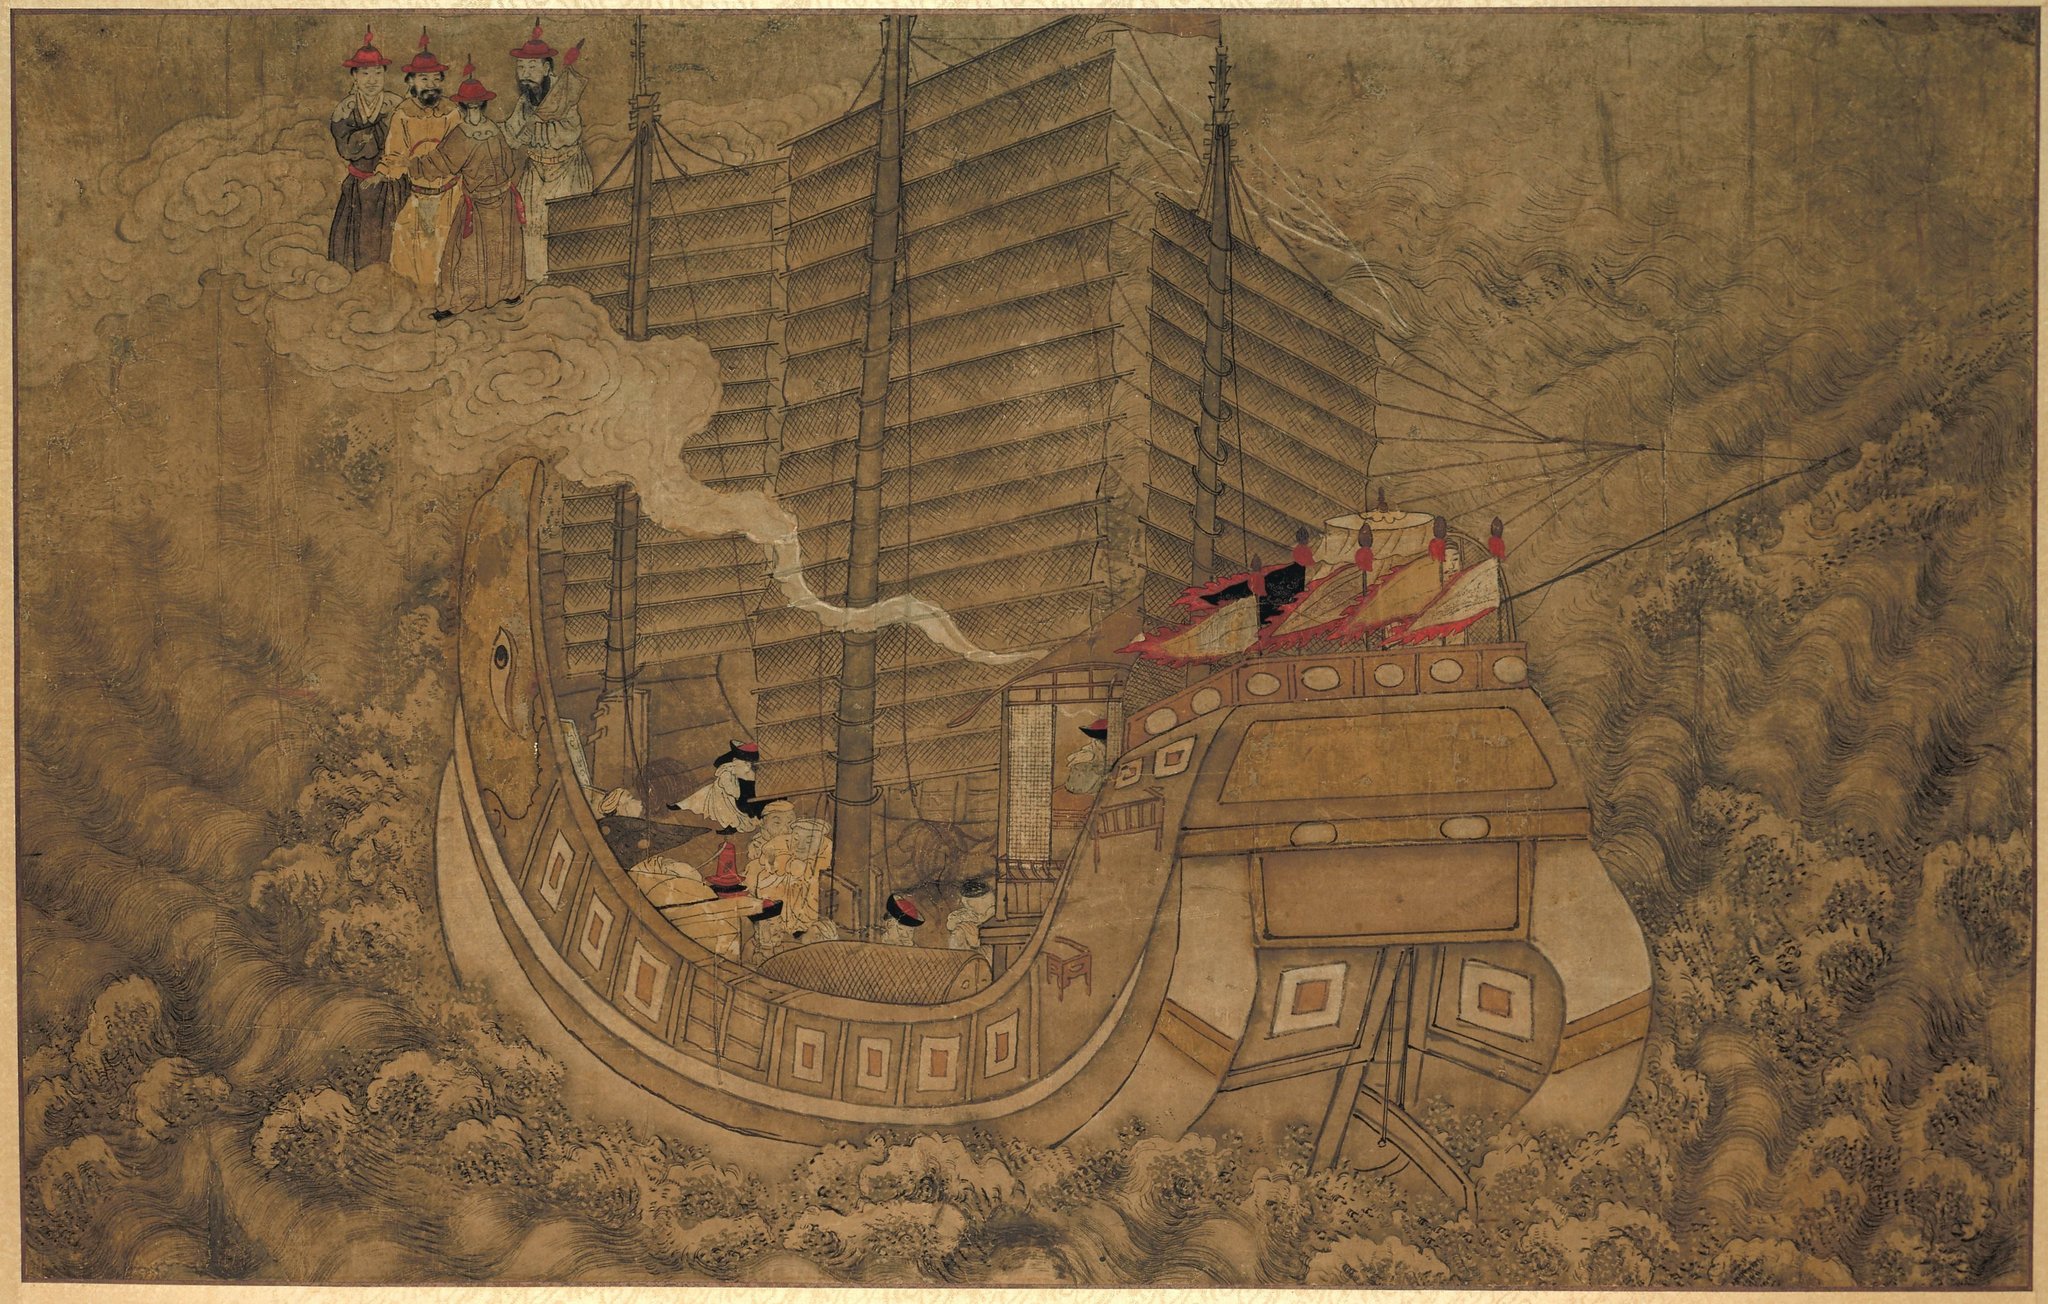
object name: album leaf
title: De wonderen van Mazu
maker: Anonymous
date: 1700-1800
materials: ink, paper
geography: china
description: Eén van een serie van zeven schilderingen die samen de wonderen van Mazu voorstellen.